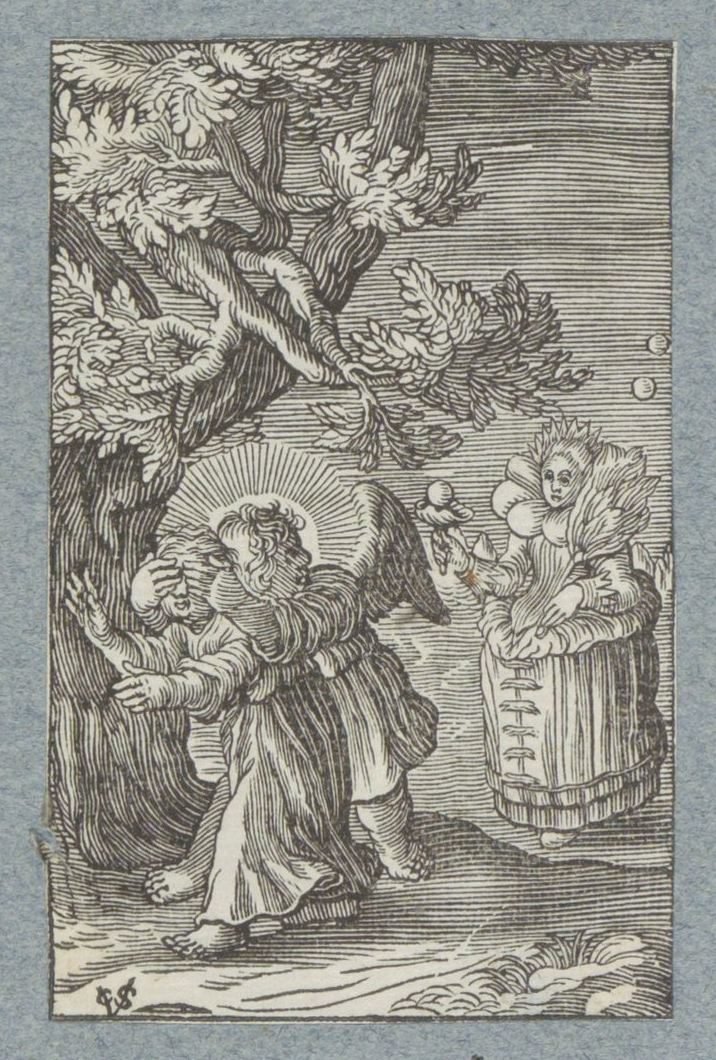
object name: print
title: Pia Desideria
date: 1628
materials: paper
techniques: woodcut, pasting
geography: amsterdam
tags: hand(s) towards the eye(s), scenes symbolizing 'vanitas'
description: Prent uit: Herman Hugo, Pia desideria emblematis, elegiis & affectibus S. S. Patrum illustrata, Antwerpen 1628. Volgens de titelpagina verscheen dit werk in Antwerpen bij Hendrick Aertssens, in werkelijkheid verscheen het in Amsterdam bij Pieter Jacobsz Paets (Dietz 2012, p. 58-59).